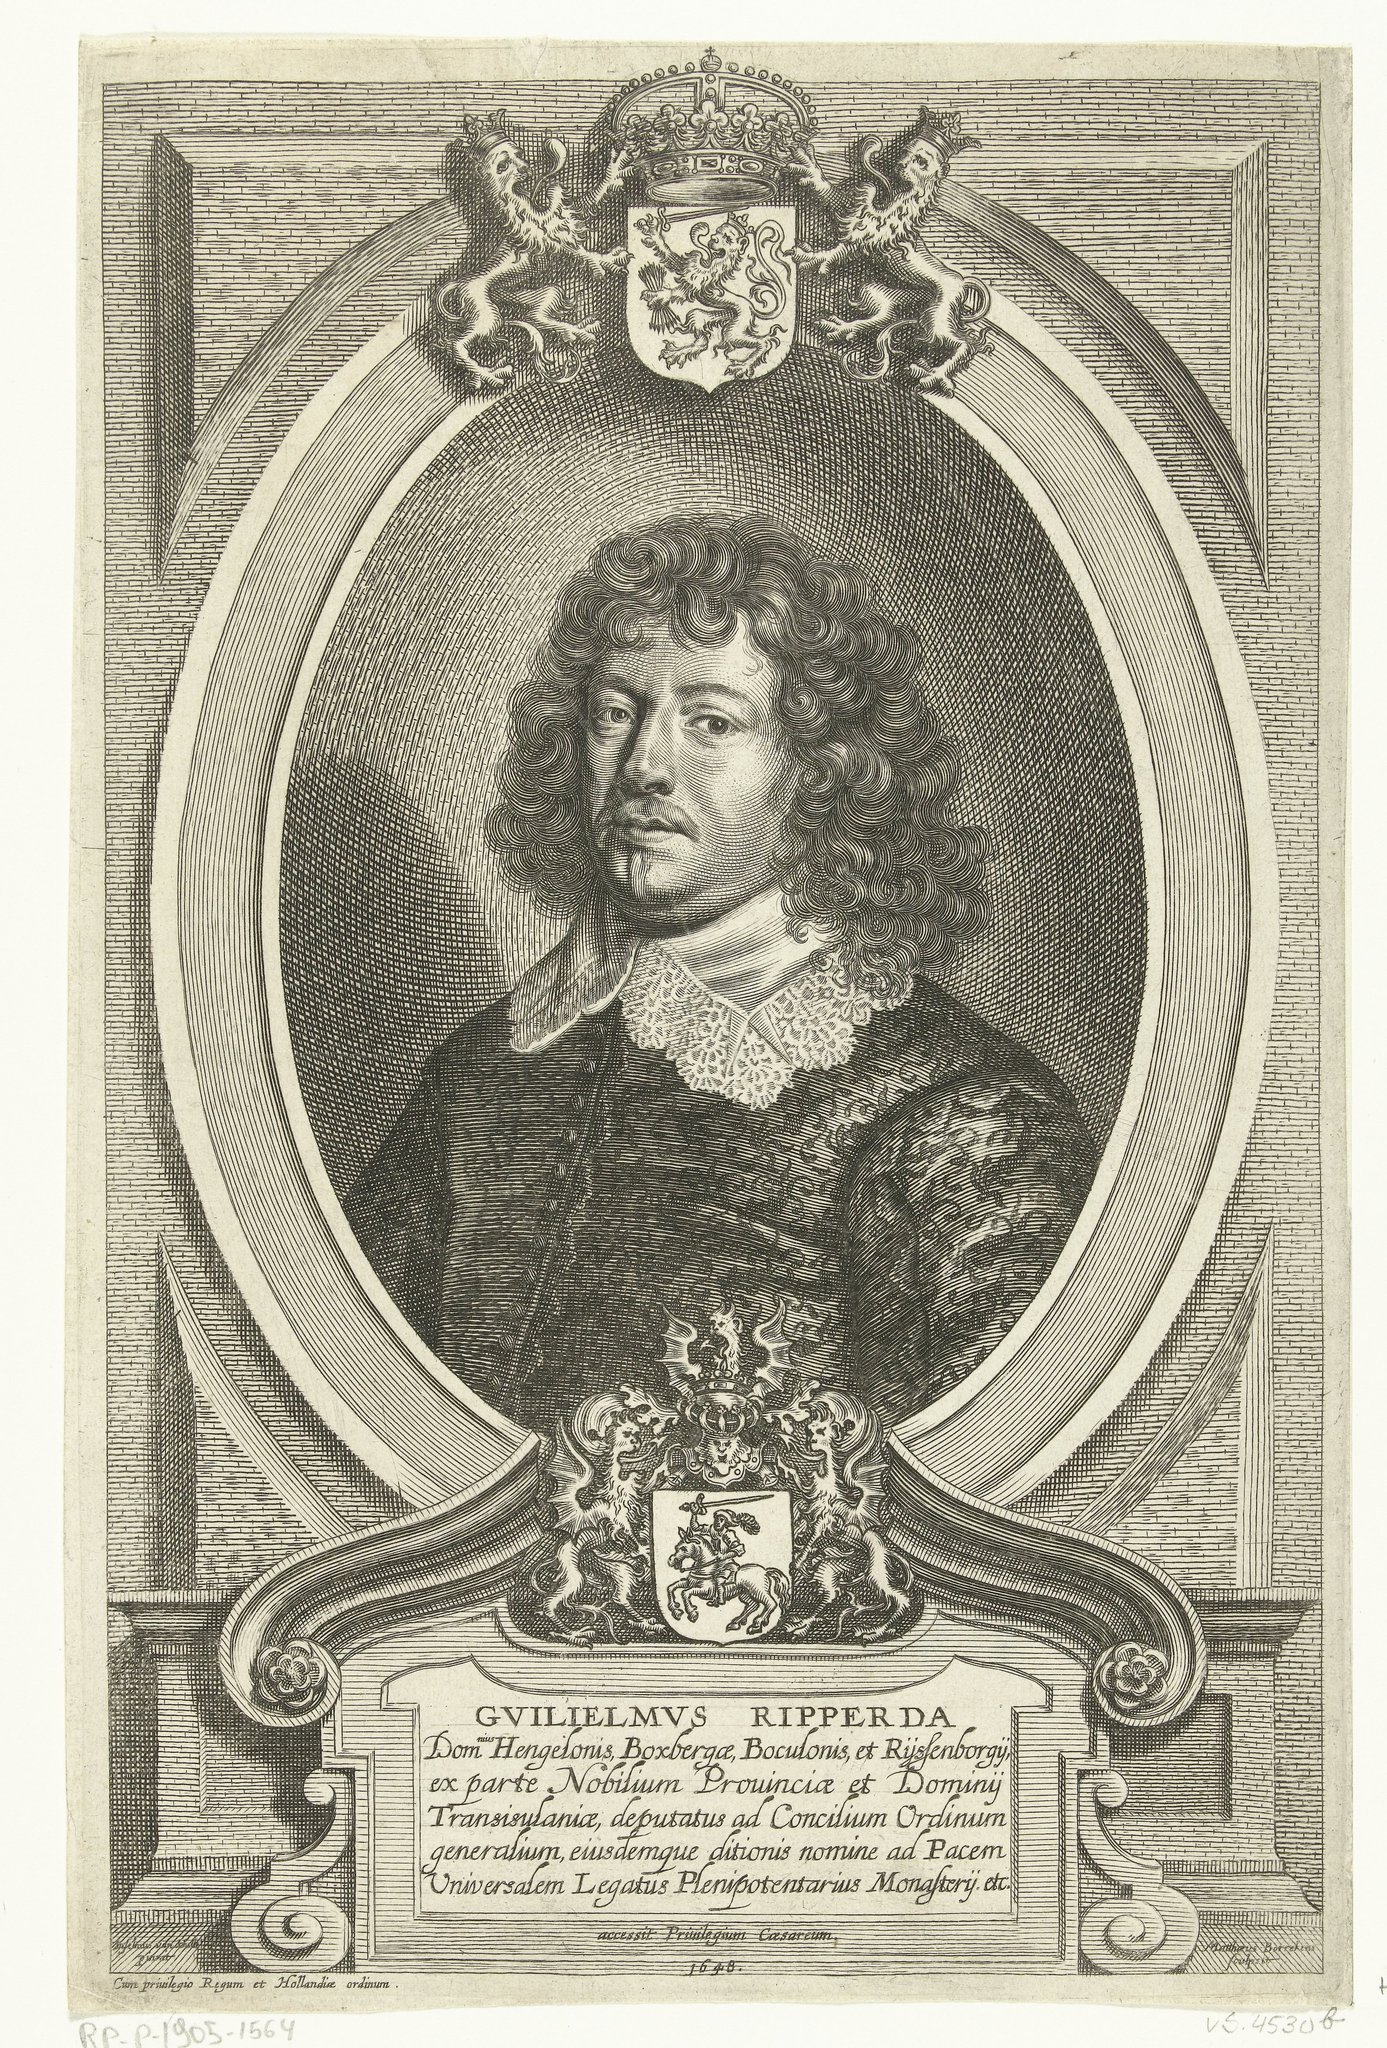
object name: print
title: Portretten van onderhandelaars bij de Vrede van Munster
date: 1648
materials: paper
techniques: engraving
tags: willem van ripperda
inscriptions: collector's mark: Lugt 2228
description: Willem Ripperda, onderhandelaar bij de Vrede van Munster. Portret in ovale lijst met buste naar links. De prent bevat een Latijns onderschrift in cartouche, een randschrift en ornament met wapen bovenaan.